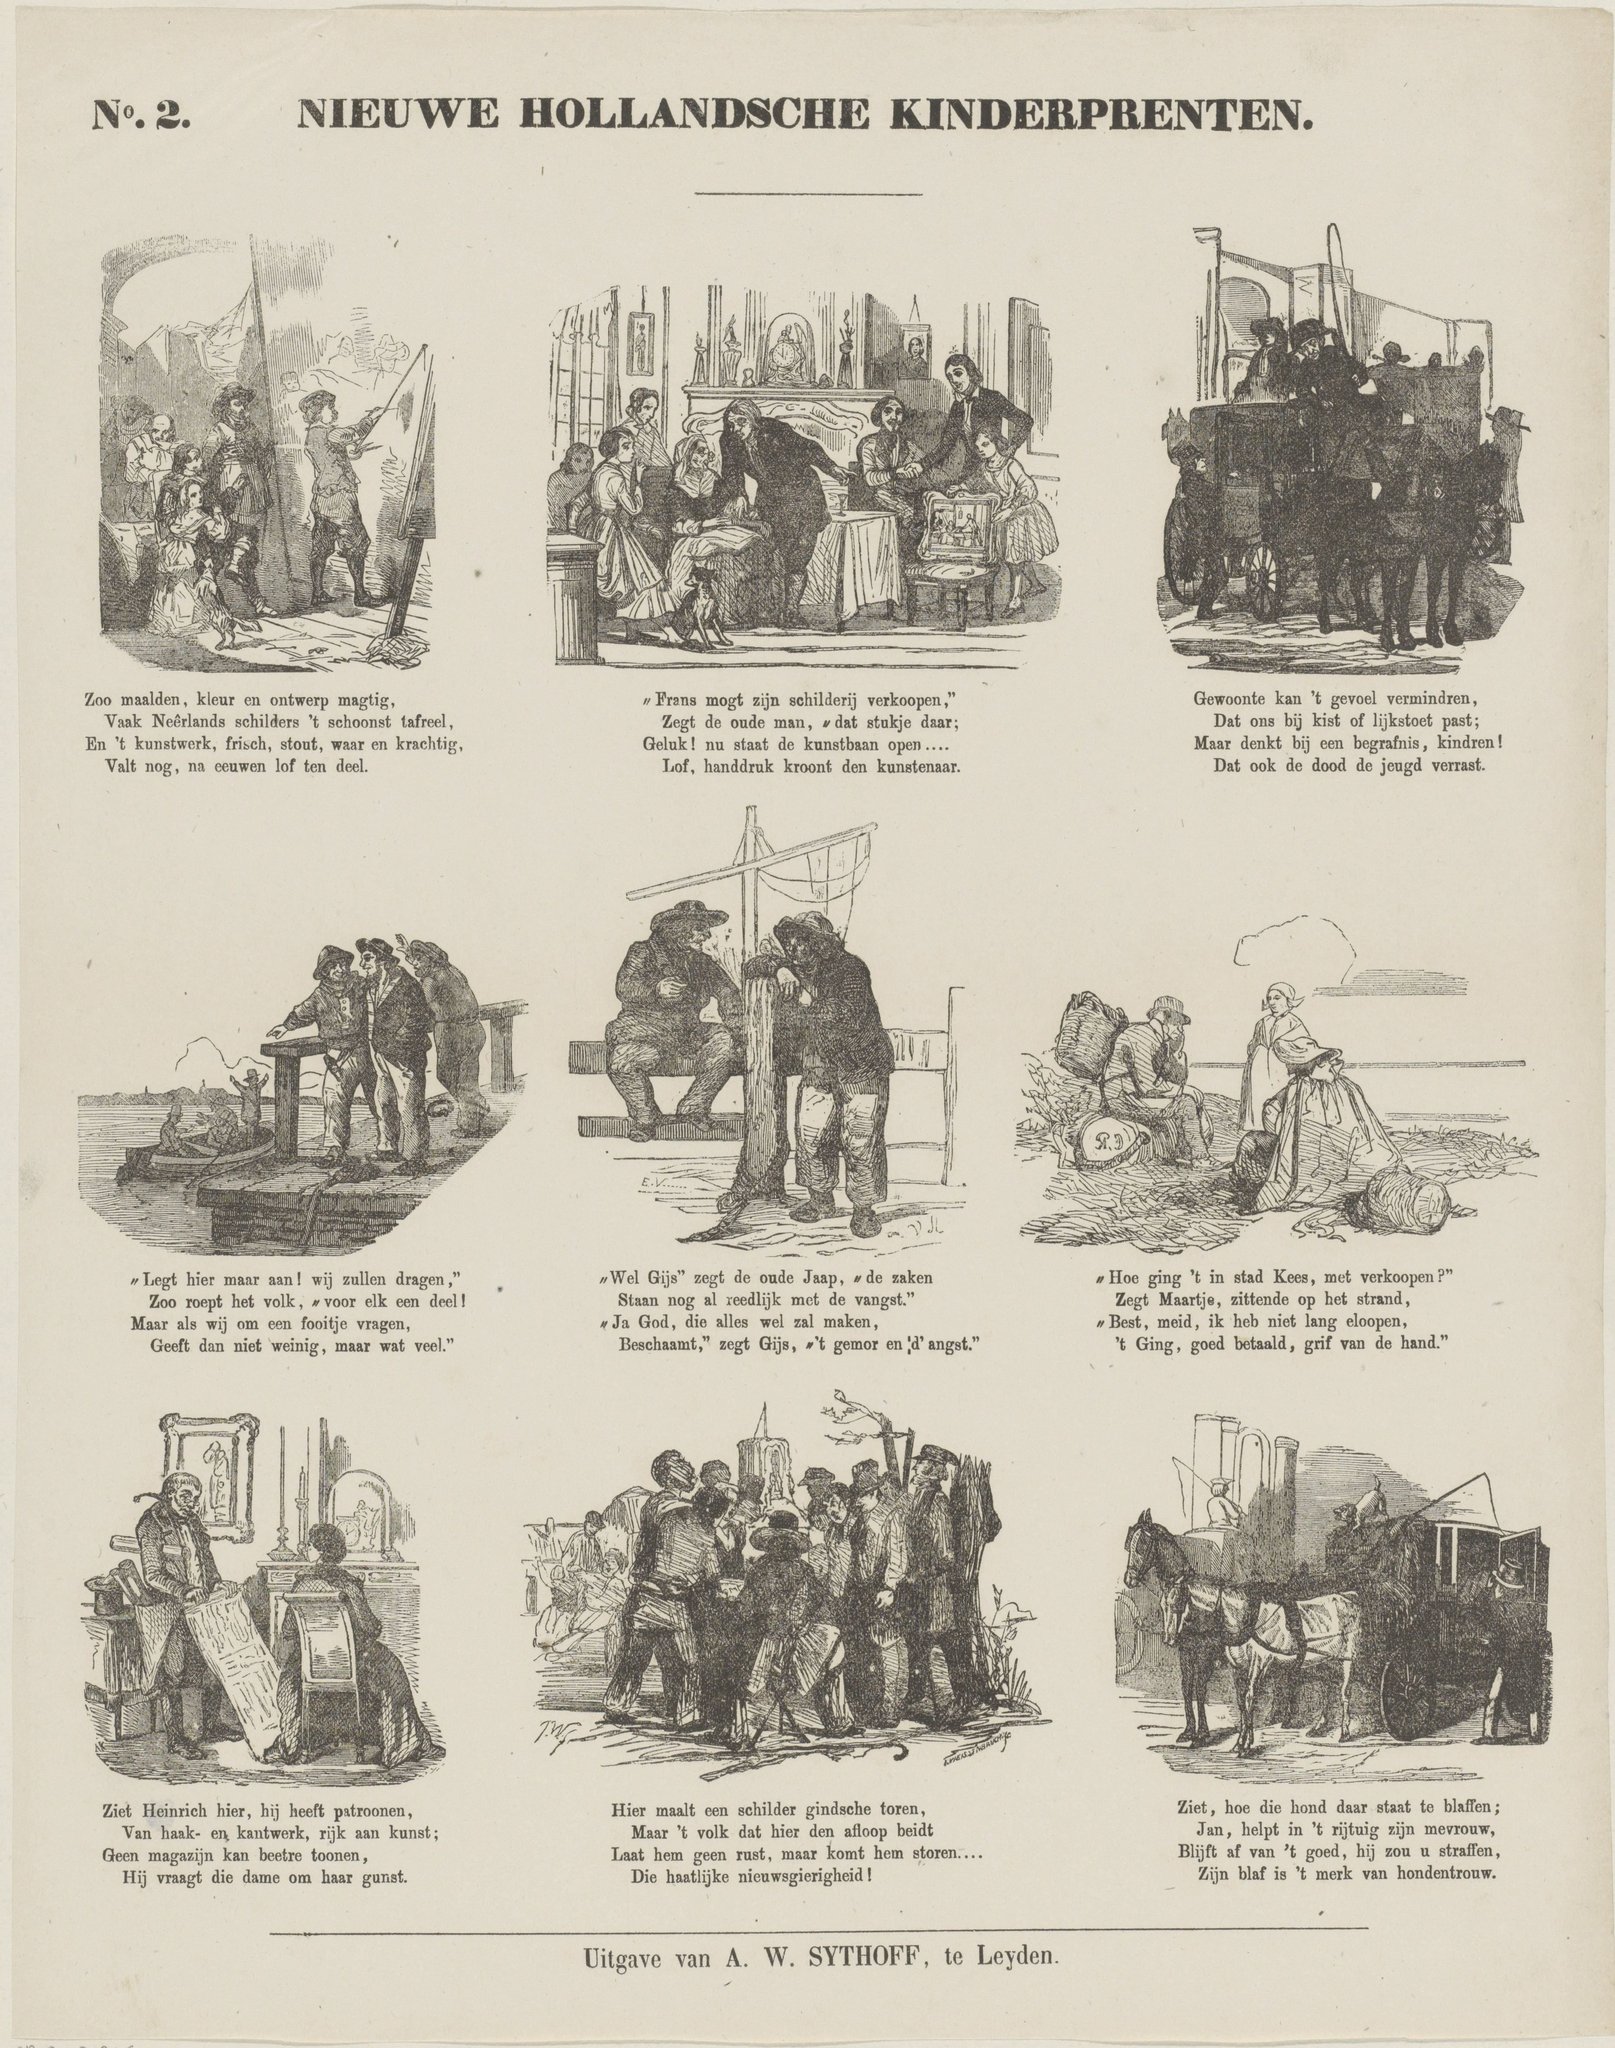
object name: print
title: Nieuwe Hollandsche kinderprenten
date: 1861-1929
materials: paper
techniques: letterpress printing, engraving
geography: netherlands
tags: human types, four-wheeled, animal-drawn vehicle, e.g.: cab, carriage, coach, characters (human types), painter at work, in his studio - cc - out of doors, fisherman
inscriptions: collector's mark: Lugt 2760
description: Blad met 9 voorstellingen van verschillende aard, zoals voorstellingen van een schilder aan het werk, van vissers en van een rijtuig. Onder elke voorstelling een vierregelig vers. Genummerd linksboven: No. 2.